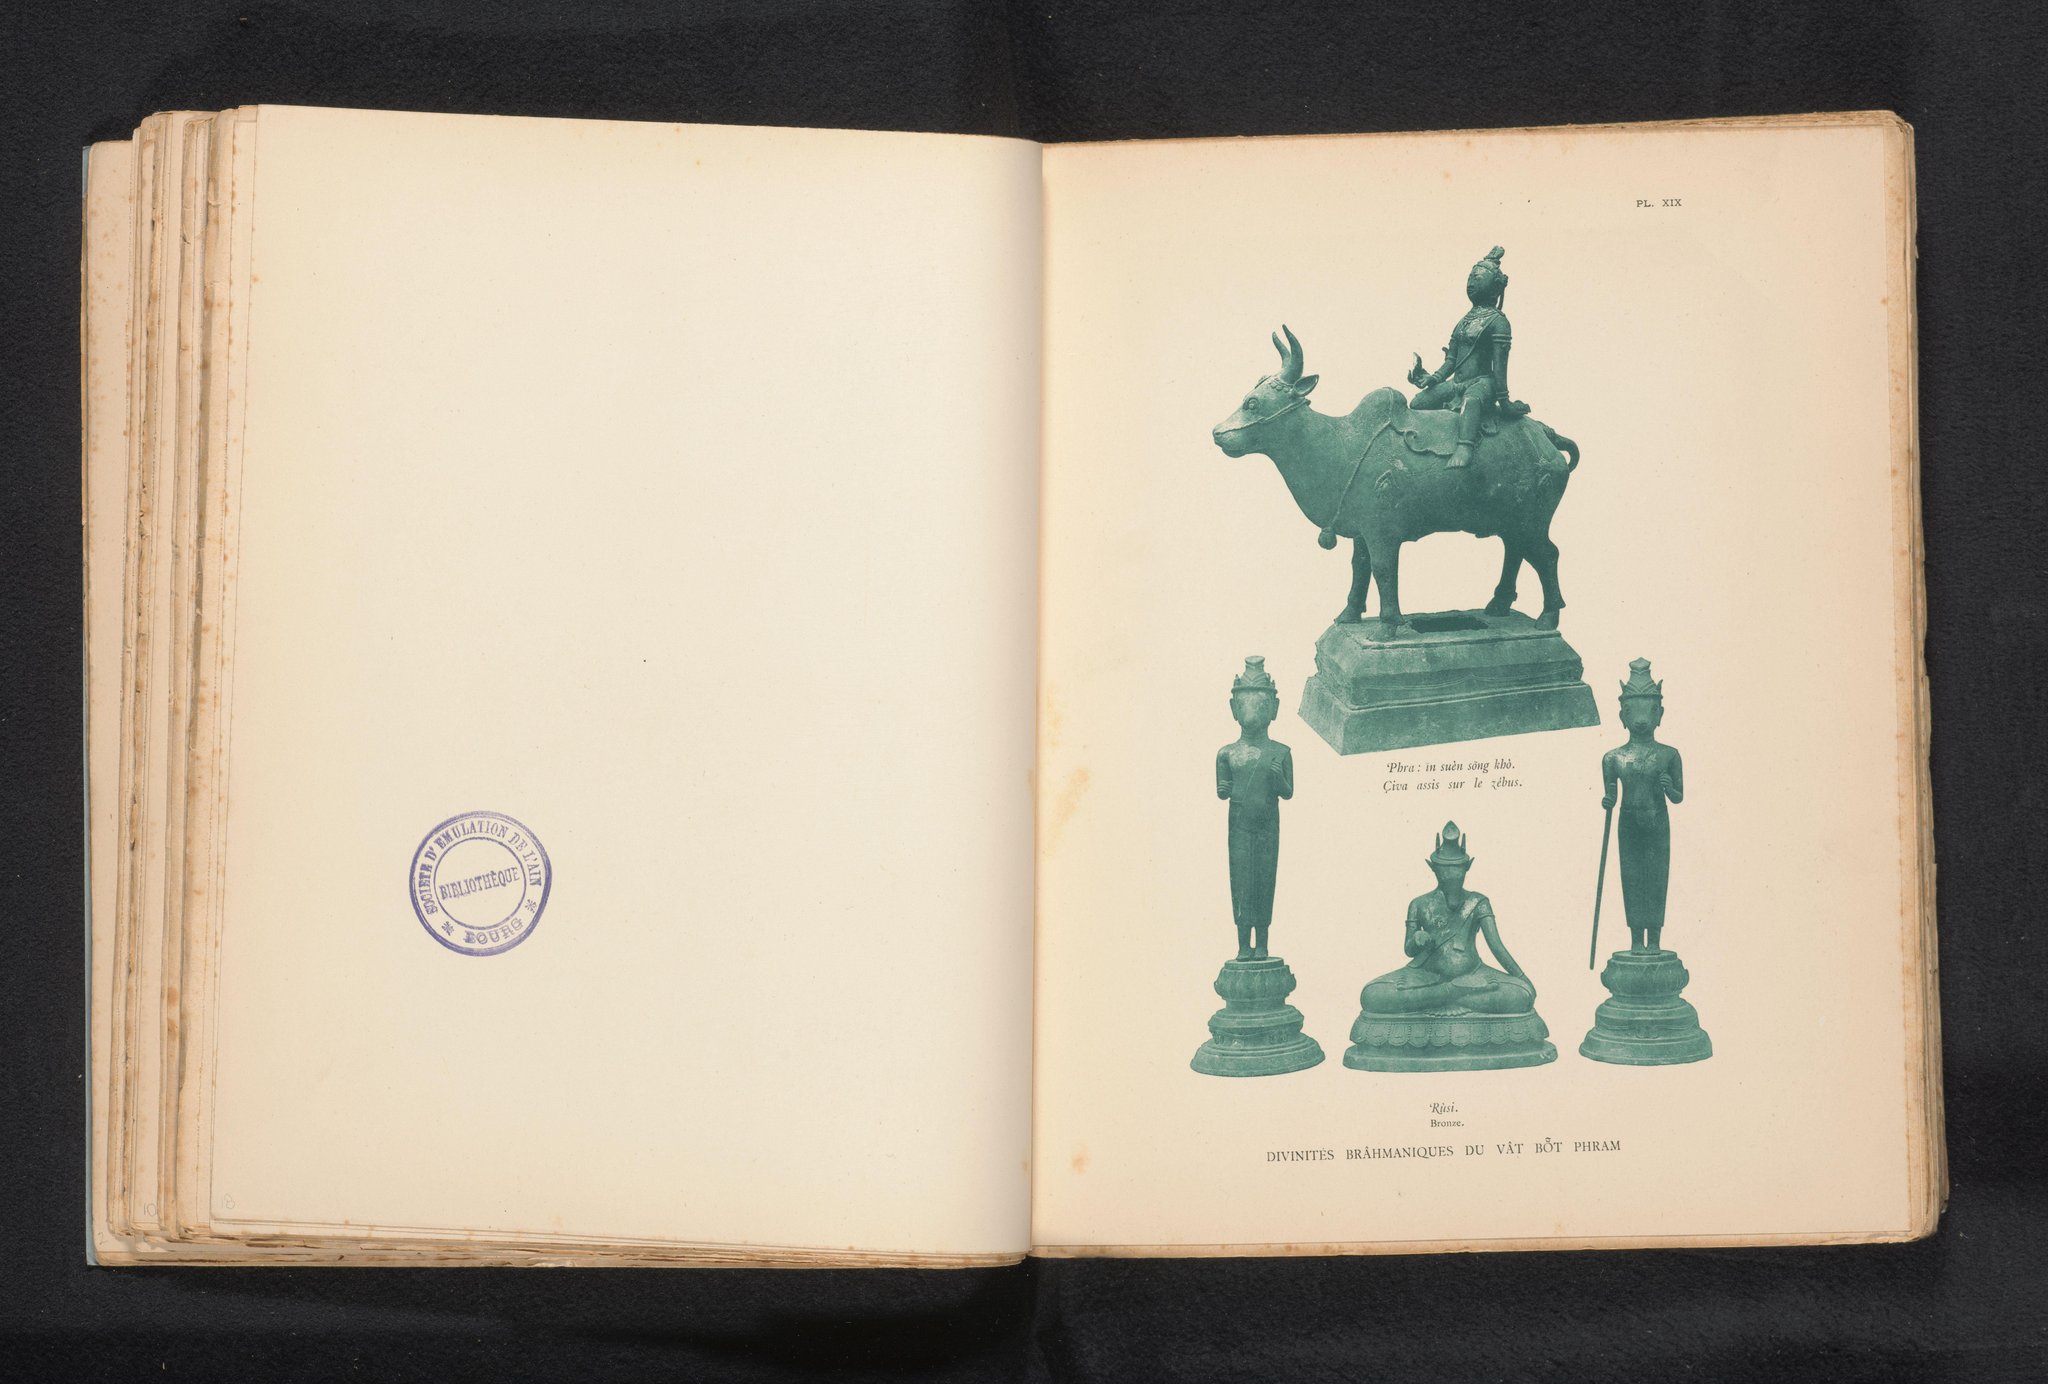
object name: page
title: Divinités brâhmaniques du Vât Bõt Phram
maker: Anonymous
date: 1890-1895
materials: paper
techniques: photograph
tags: hinduism, buddhism, jainism, sculpture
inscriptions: inscription: ‘Phra : ïn suèn sŏng khò. Civa assis sur le zébus./ Rùsi./ Bronze.’, collector's mark: ‘Société d'Emulation de l'Ain/ Bourg/ Bibliothèque’, inscription: ‘Pl. XIX’